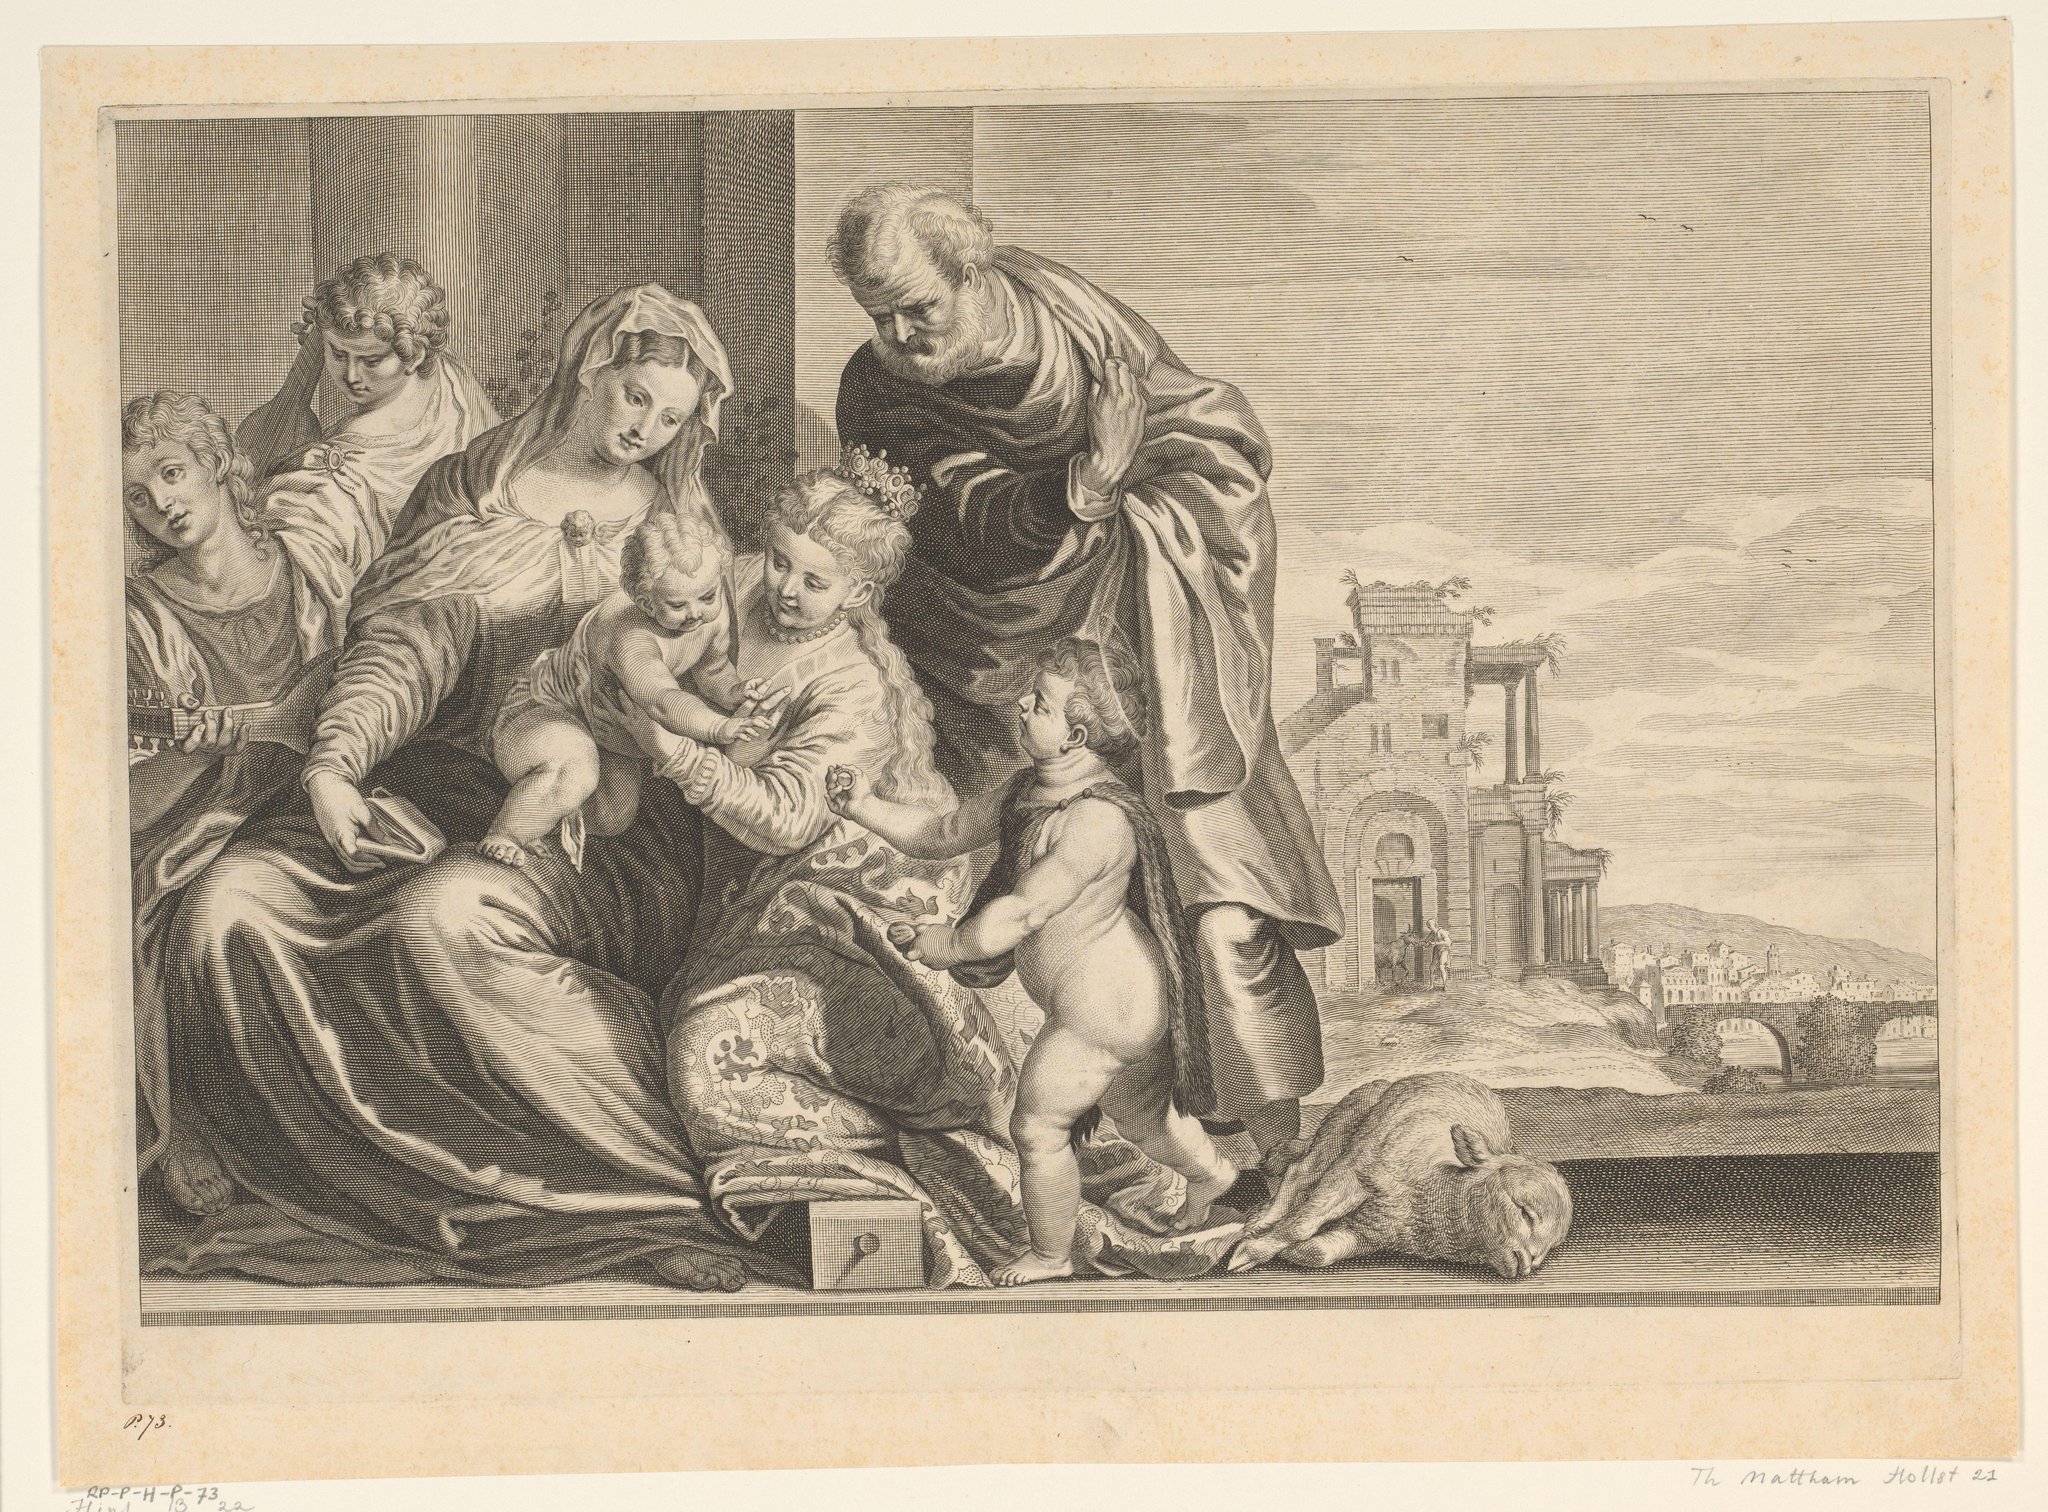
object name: print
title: Heilige familie met H. Catharina en Johannes de Doper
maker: theodor matham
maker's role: draughtsman, print maker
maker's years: 1605-1676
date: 1646-1658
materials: paper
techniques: engraving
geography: amsterdam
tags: holy family with john the baptist (as child), the mystic marriage of st. catherine of alexandria with the infant christ: the christ-child puts a ring on her finger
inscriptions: collector's mark: Lugt 11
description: Deze prent maakte ten minste tot 1979 deel uit van een prentalbum met de titel: 't Cabinet der Italiaense schilderije antique statue en borstbeelde van de heer Renst 145 stucks. Simon Schijnvoet heeft in 1709 aan dit album het Schijnvoet-nummer 22, liber nummer 20 toegekend. Prent uit serie Caelaturae met vierendertig reprodukties naar Italiaanse en Nederlandse schilders, vervaardigd door de allerbeste graveurs in opdracht van de verzamelaar Gerard Reynst.